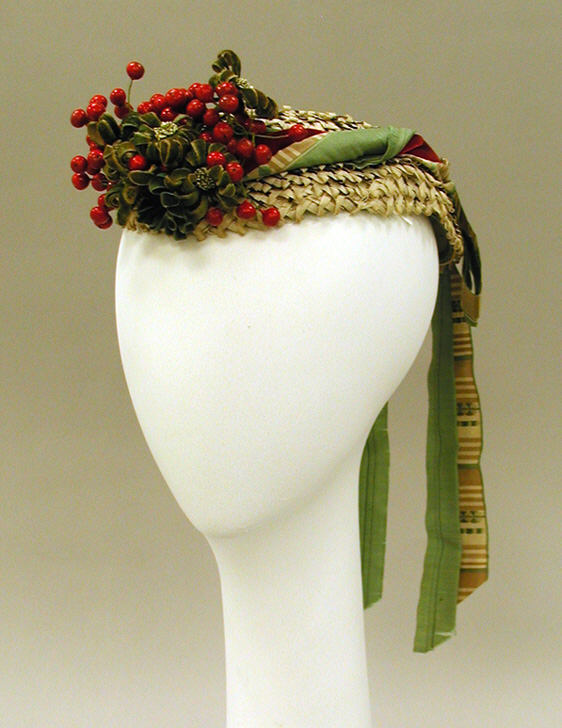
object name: hat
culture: american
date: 1867-1868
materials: silk, fiber